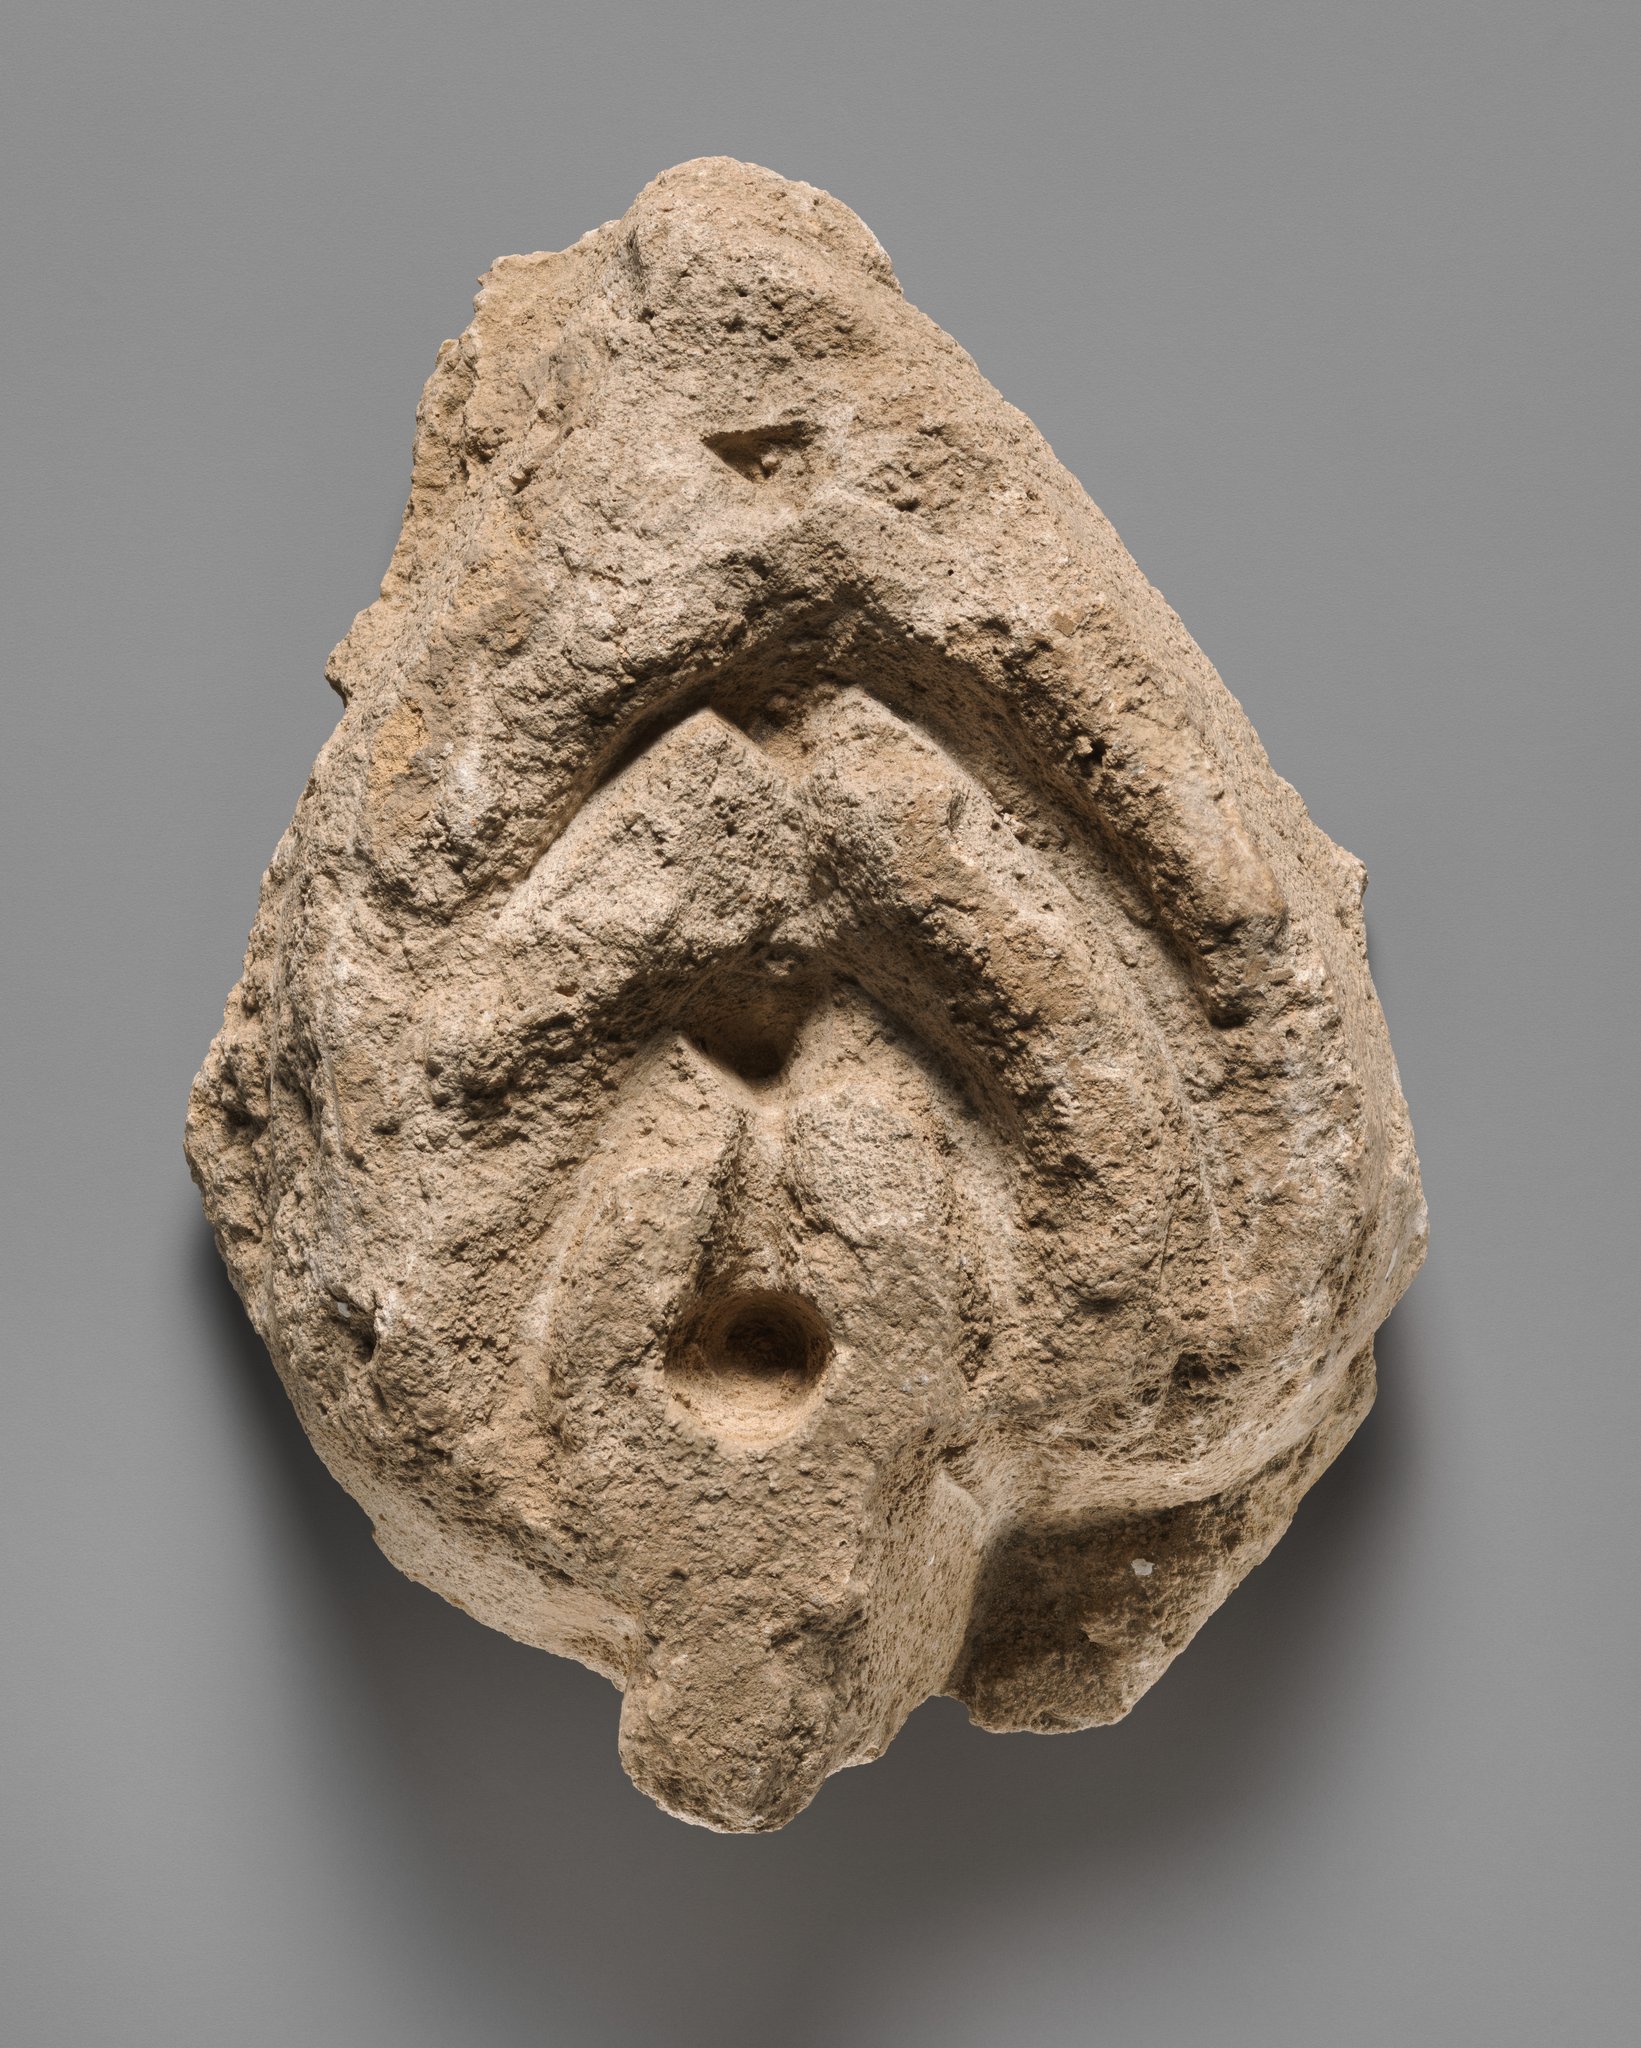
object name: relief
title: Relief fragment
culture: sasanian or islamic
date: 501-800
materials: plaster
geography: mesopotamia